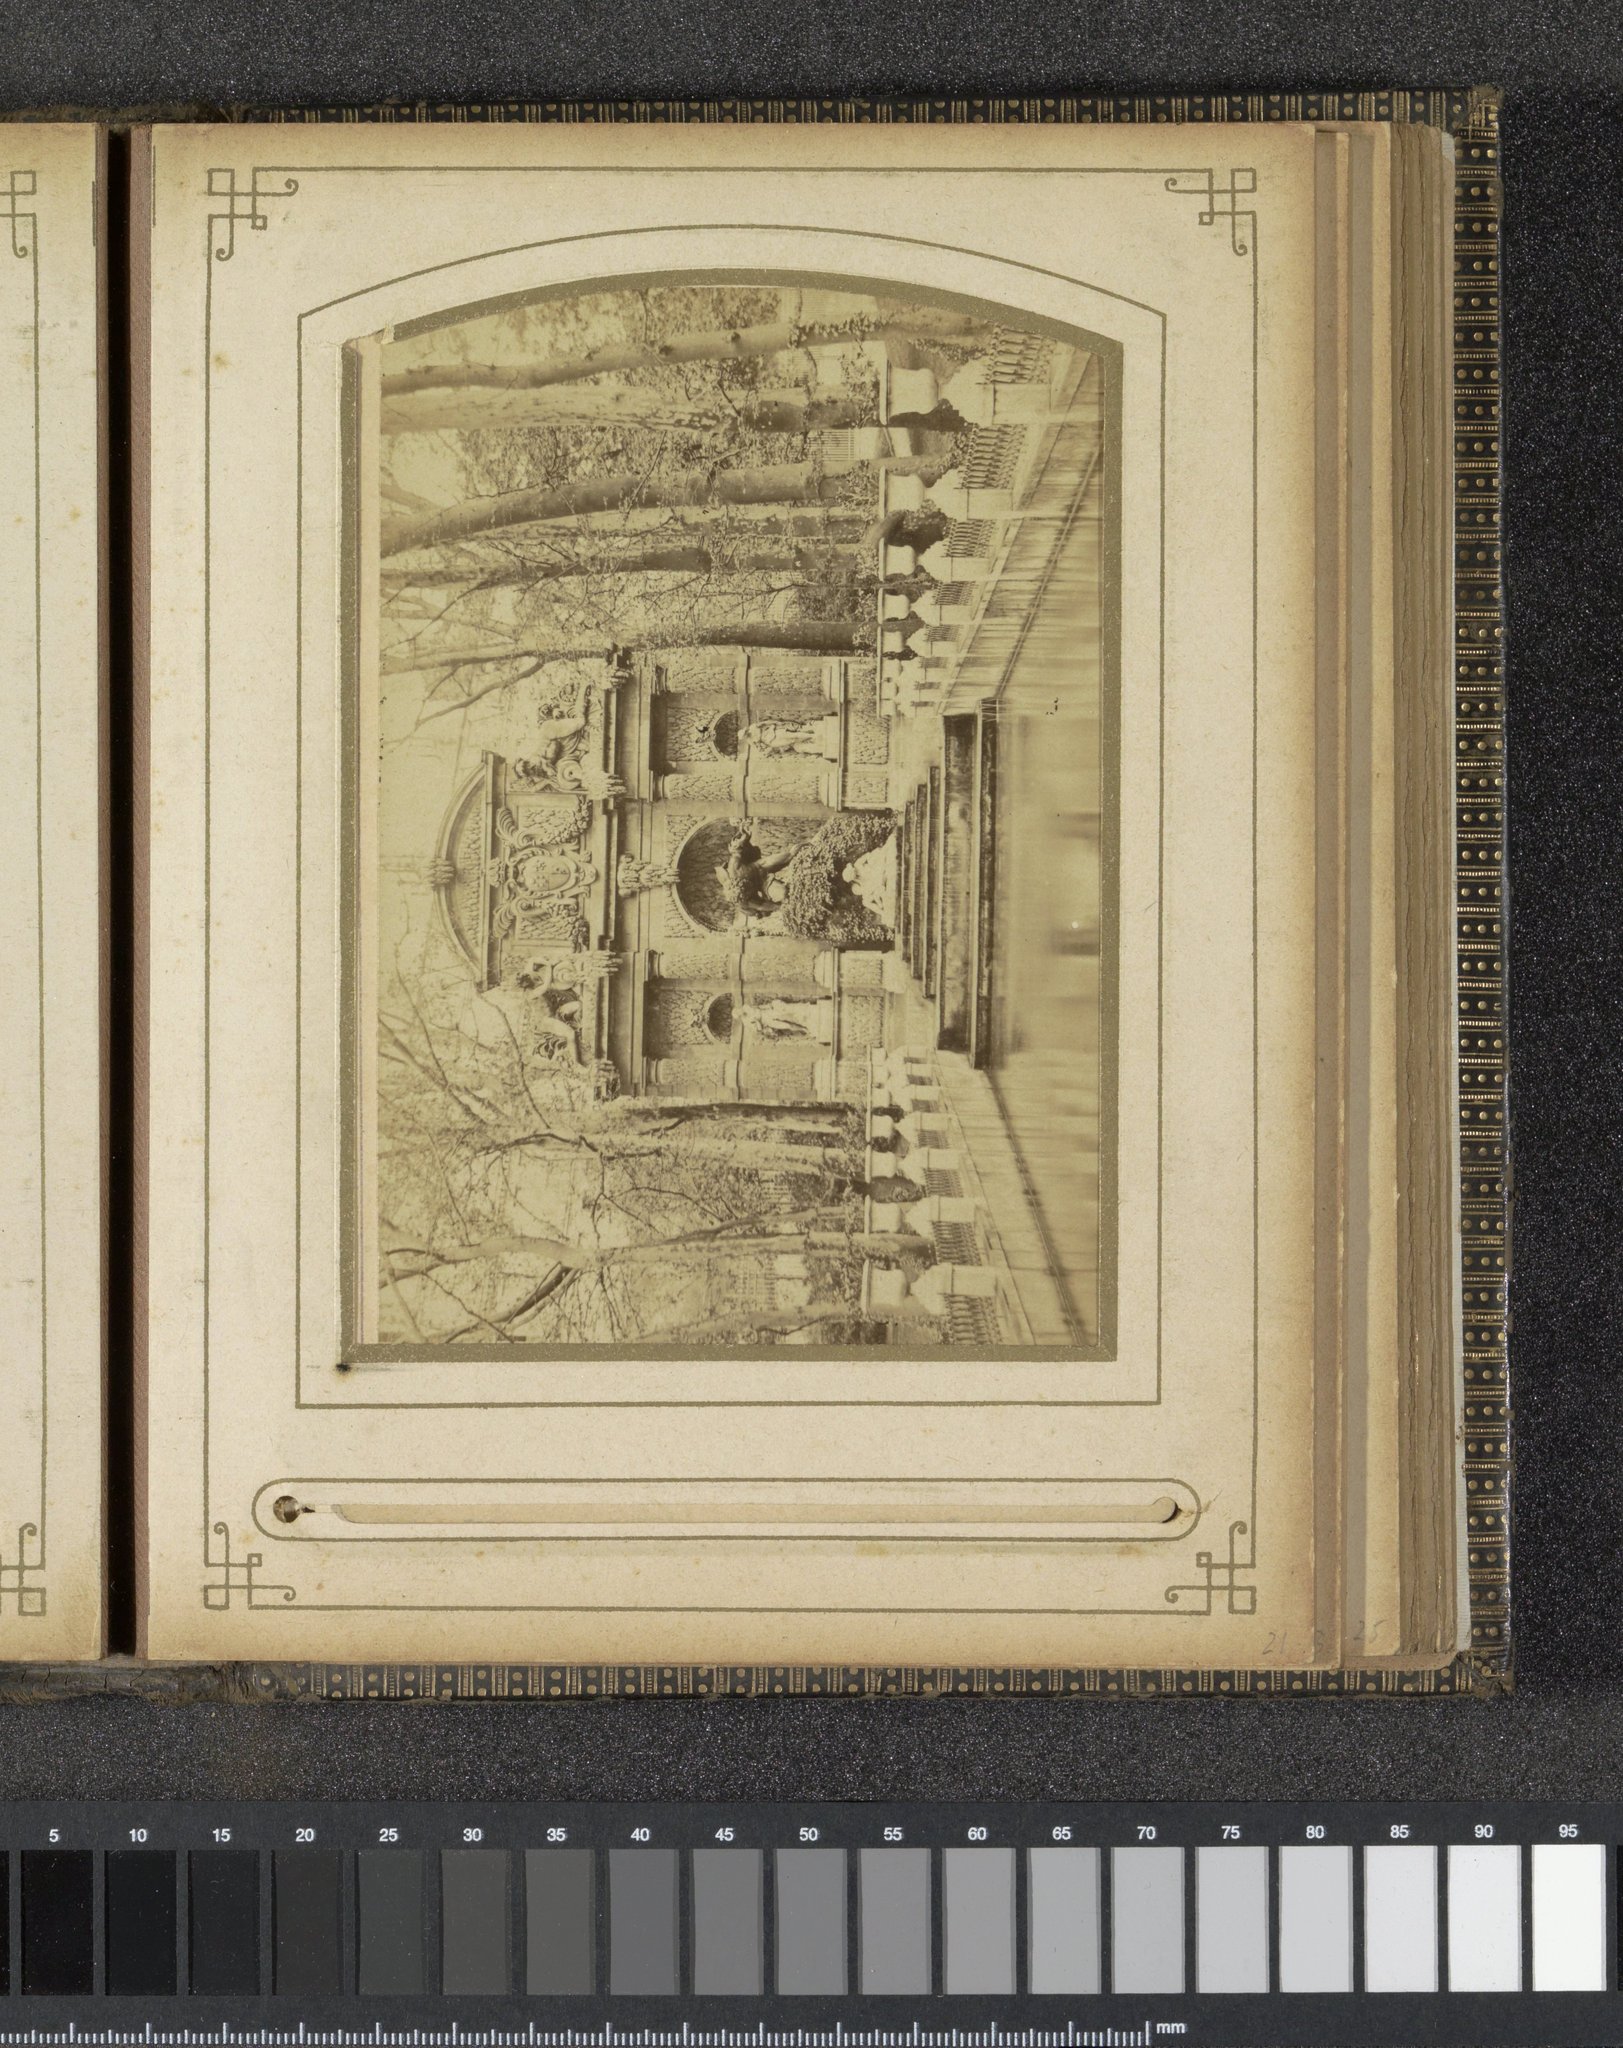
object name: cabinet photograph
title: De' Medici-fontein in de Jardin du Luxembourg in Parijs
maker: Anonymous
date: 1870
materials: cardboard, paper, photographic support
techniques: albumen print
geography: paris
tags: ornamental fountain (+ city(-scape) with figures, staffage), public gardens, park, paris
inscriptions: inscription: ‘Fontaine de Medici Jardin de Luxembourg’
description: Onderdeel van Fotoalbum met kabinetfoto's van bezienswaardigheden in Parijs.